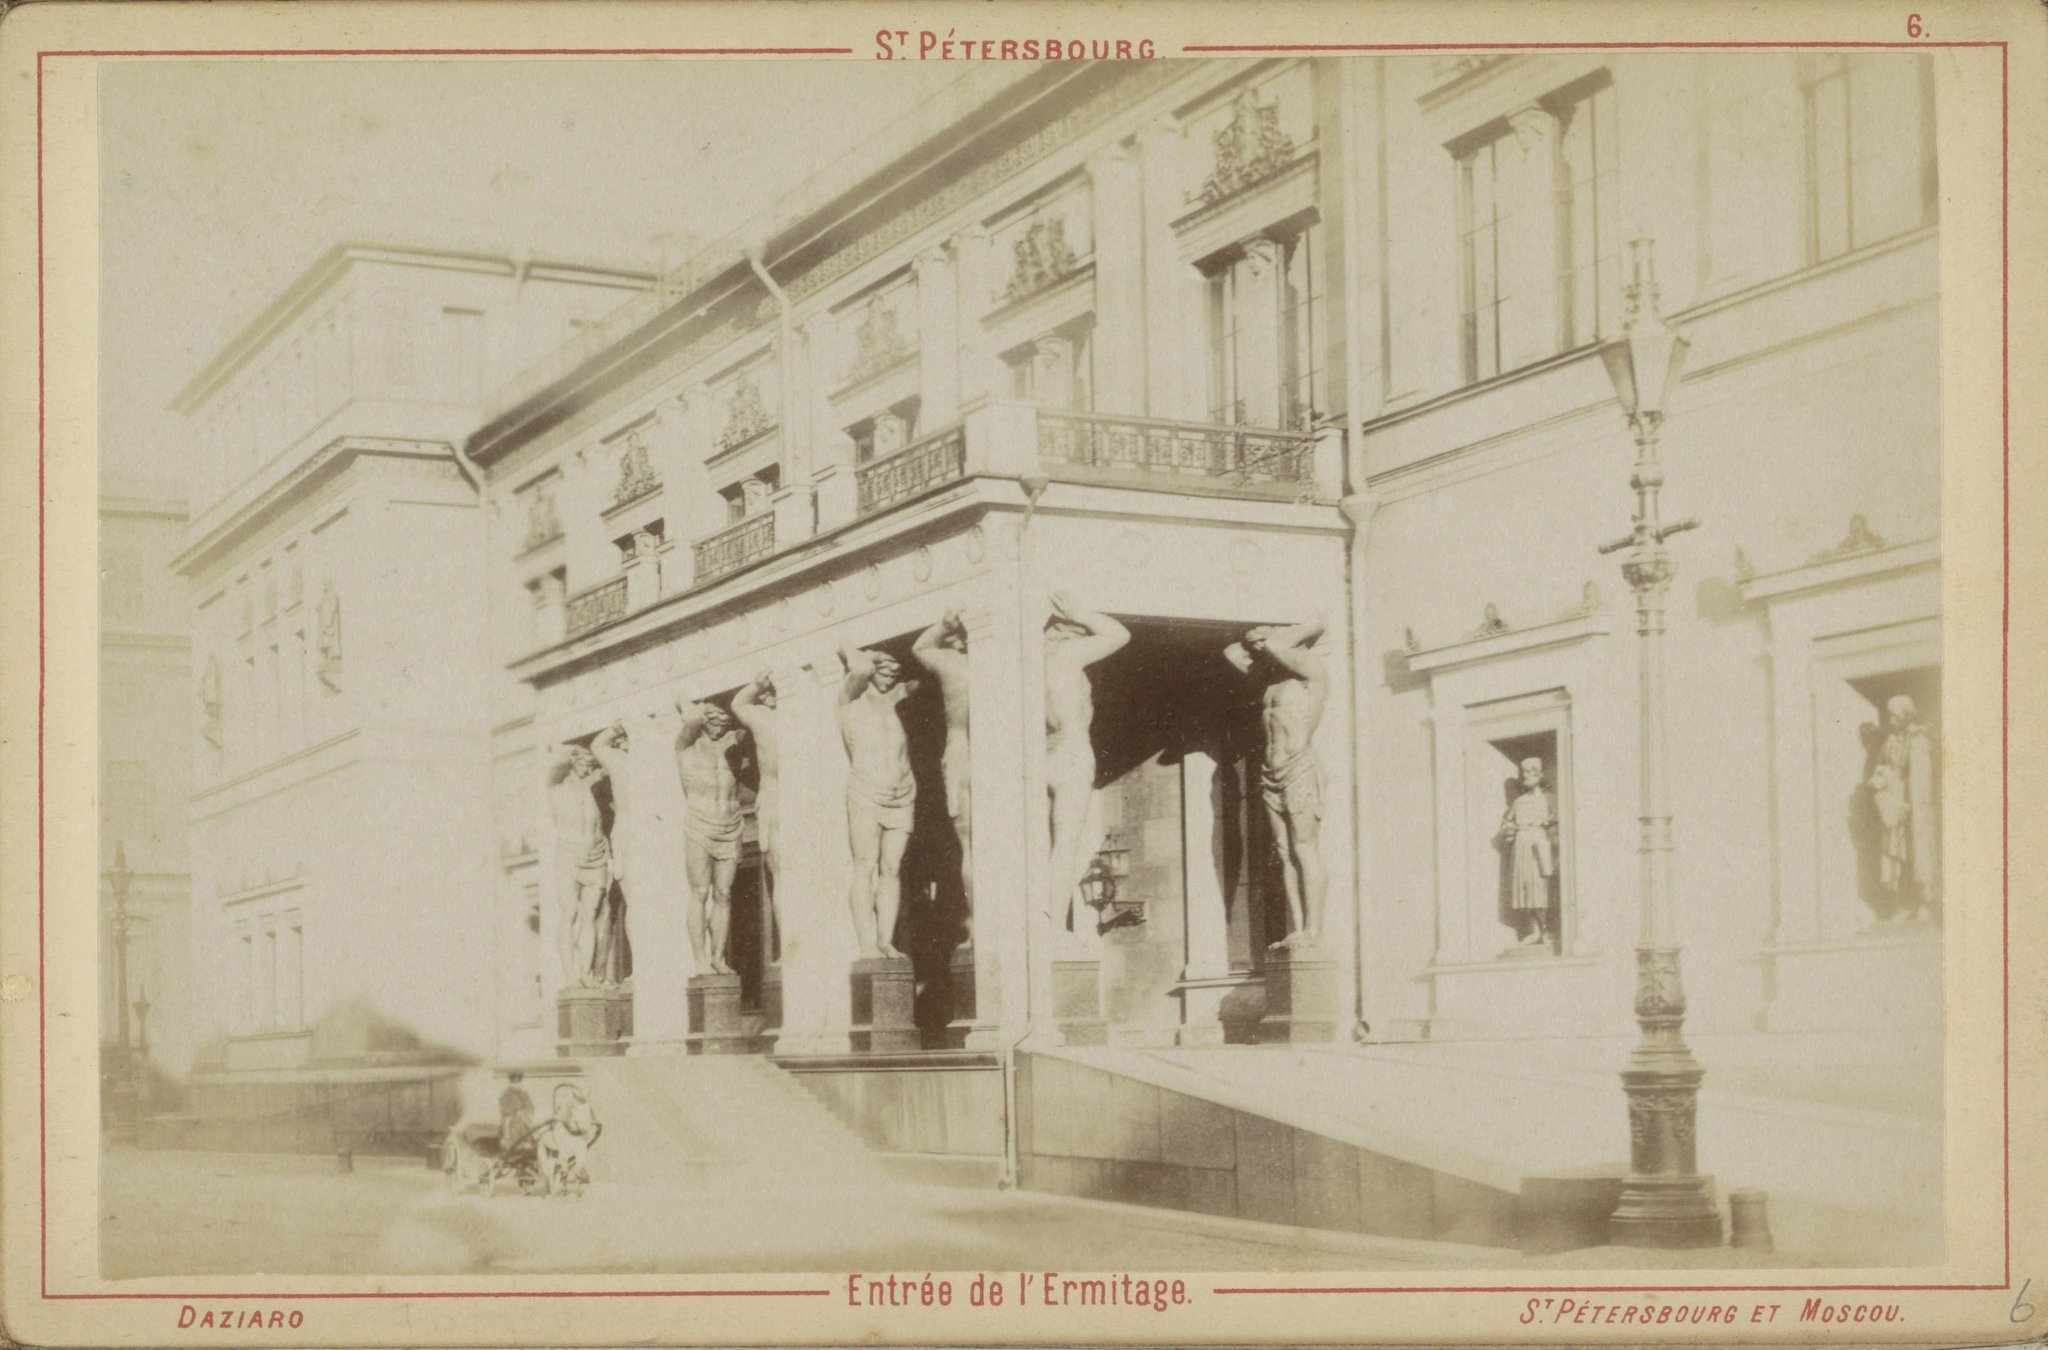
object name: photograph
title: St. Pétersbourg. Entrée de l'Ermitage.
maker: joseph daziaro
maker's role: publisher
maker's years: 1831-1892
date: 1880-1900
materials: cardboard, photographic support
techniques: albumen print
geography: sint-petersburg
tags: atlantes ~ architecture, gate, entrance, permanent exhibition, museum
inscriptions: number: ‘6.’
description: Onderdeel van Leporelloalbum met opnames van Sint-Petersburg.